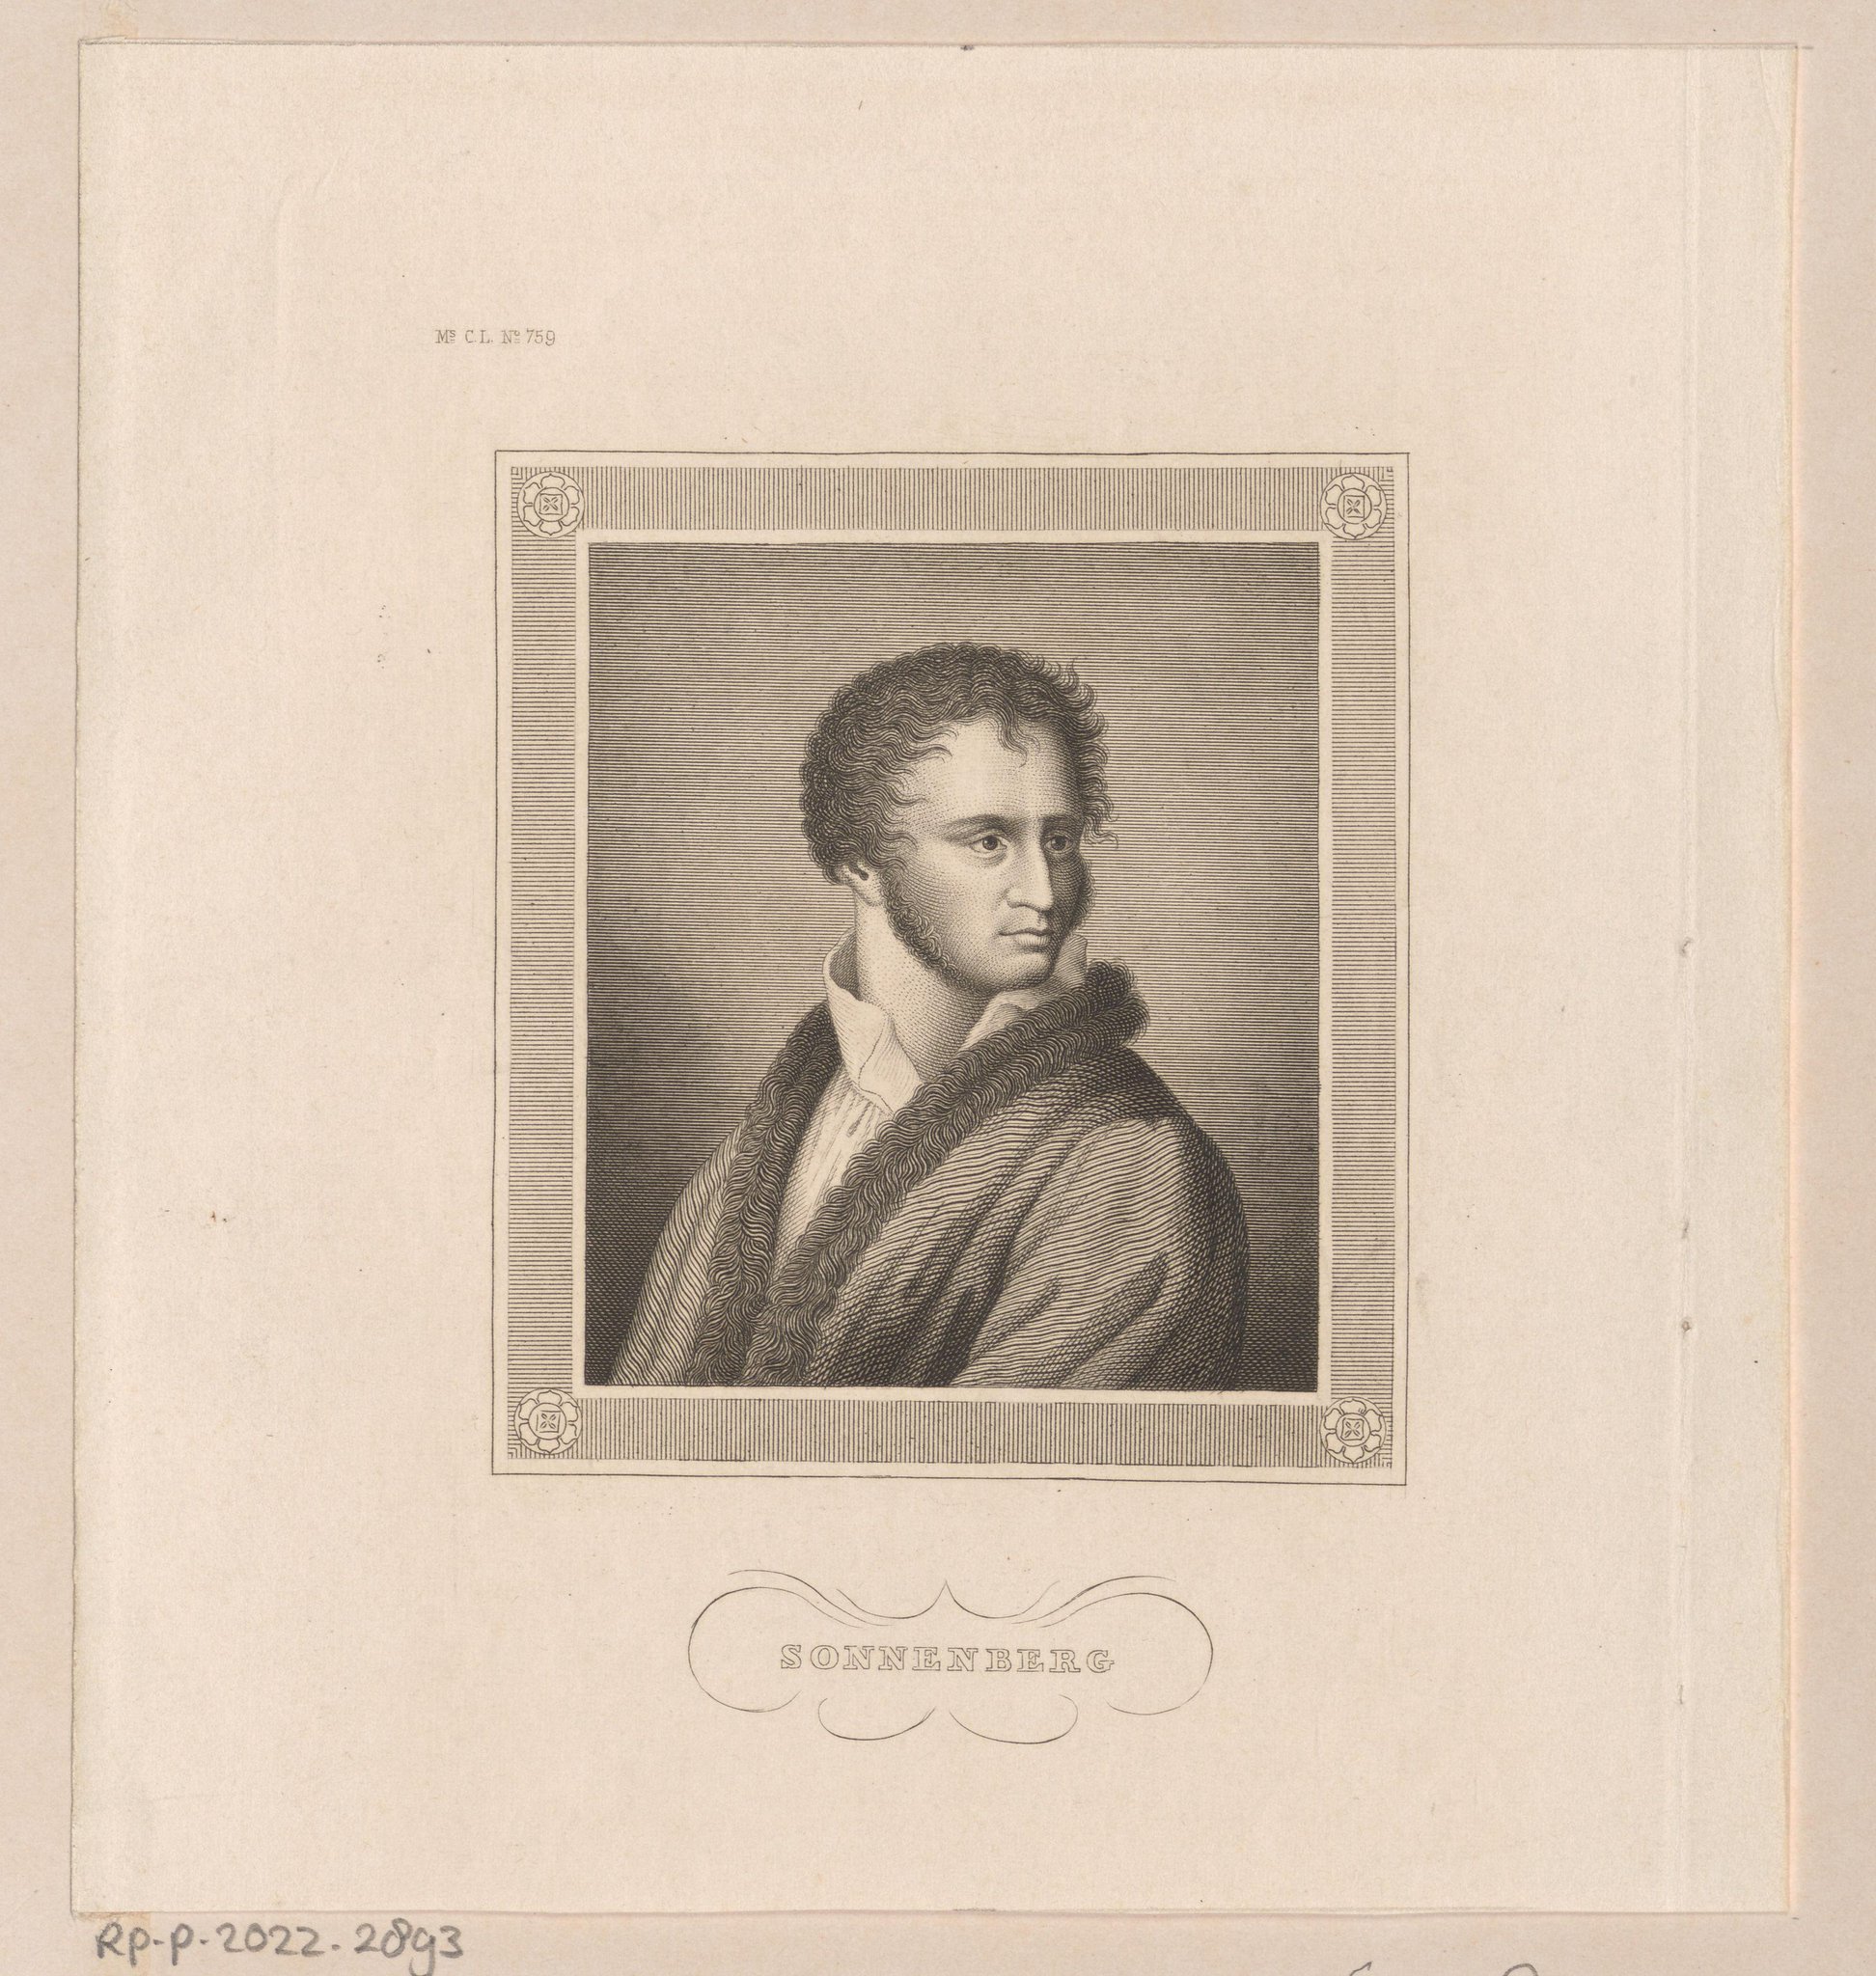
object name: print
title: Portret van Franz Anton von Sonnenberg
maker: Anonymous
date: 1839-1855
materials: paper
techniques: engraving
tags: historical persons, writer, poet, author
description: Prent uit: Meyer, Joseph. Das große Conversations-Lexikon für die gebildeten Stände. 52 dln. Hildburghausen: Bibliographisches Institut, [1839-1855].